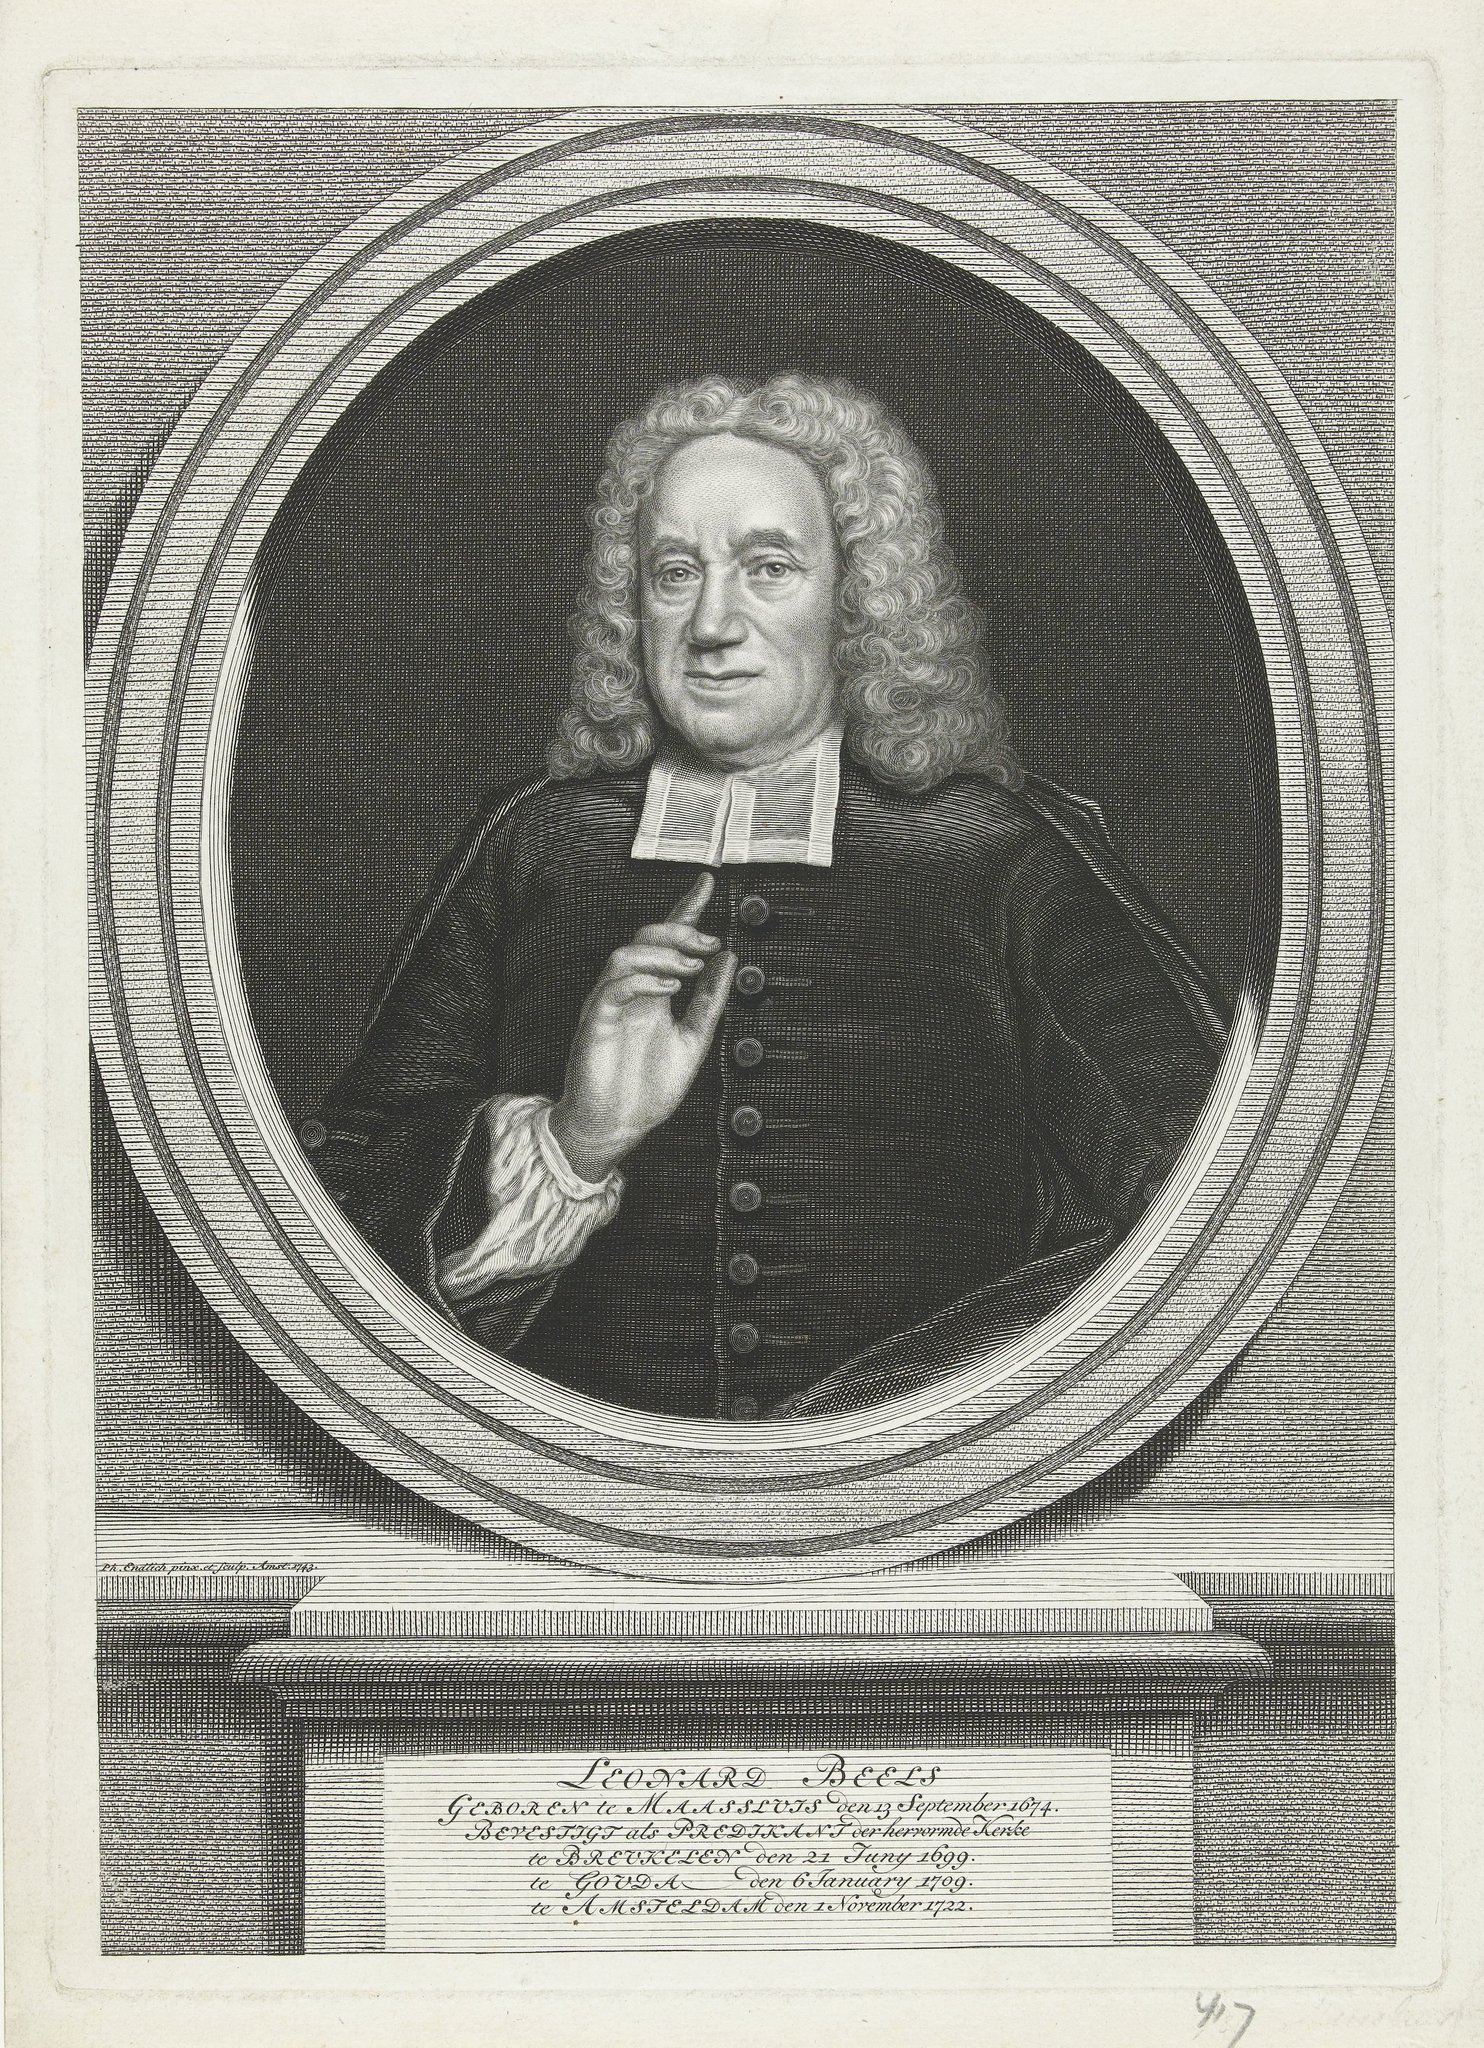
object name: print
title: Portret van Leonard Beels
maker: philippus endlich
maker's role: draughtsman, print maker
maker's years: 1700-1748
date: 1743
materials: paper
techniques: engraving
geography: amsterdam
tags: netherlands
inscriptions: collector's mark: Lugt 2228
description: Portret van de predikant Leonard Beels, afgebeeld met één hand zichtbaar, in ovale omlijsting. Onder de lijst een console met een Nederlandse tekst van zes regels.